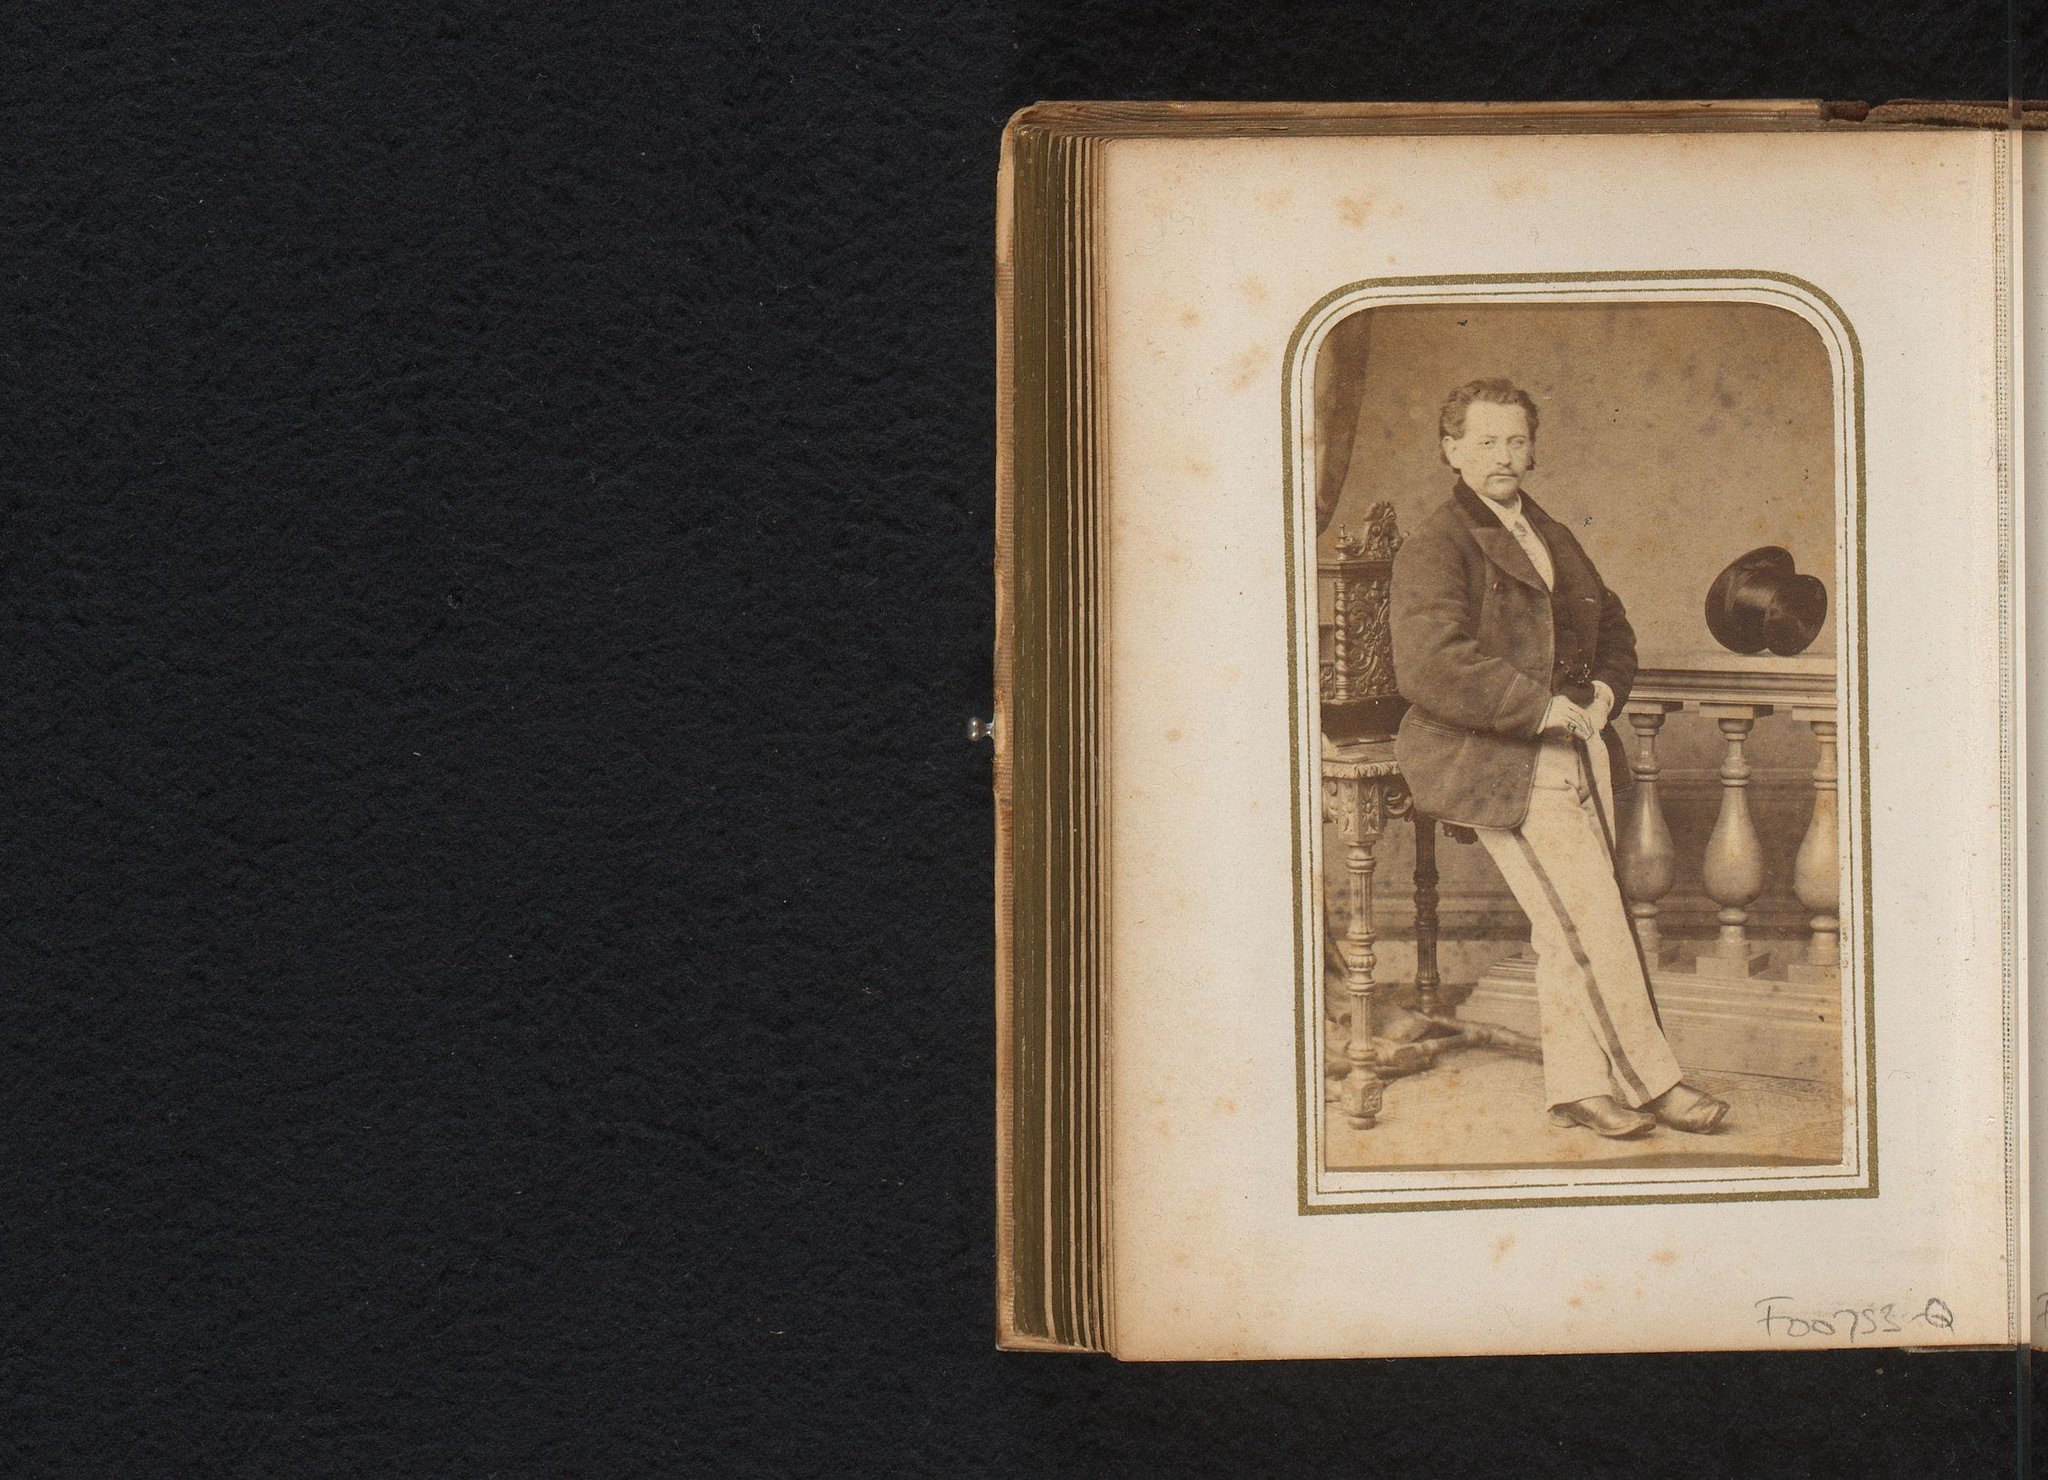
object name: photograph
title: Portret van een staande man met wandelstok en naast hem een hoge hoed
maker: pieter cornelis mondt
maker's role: fotograaf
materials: cardboard, photographic support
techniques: albumen print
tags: walking-stick, staff, adult man, historical persons, head-gear: top hat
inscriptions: inscription: ‘P.C. Mondt/ Photographe/ Kerkplein 71/'s Gravenhage’